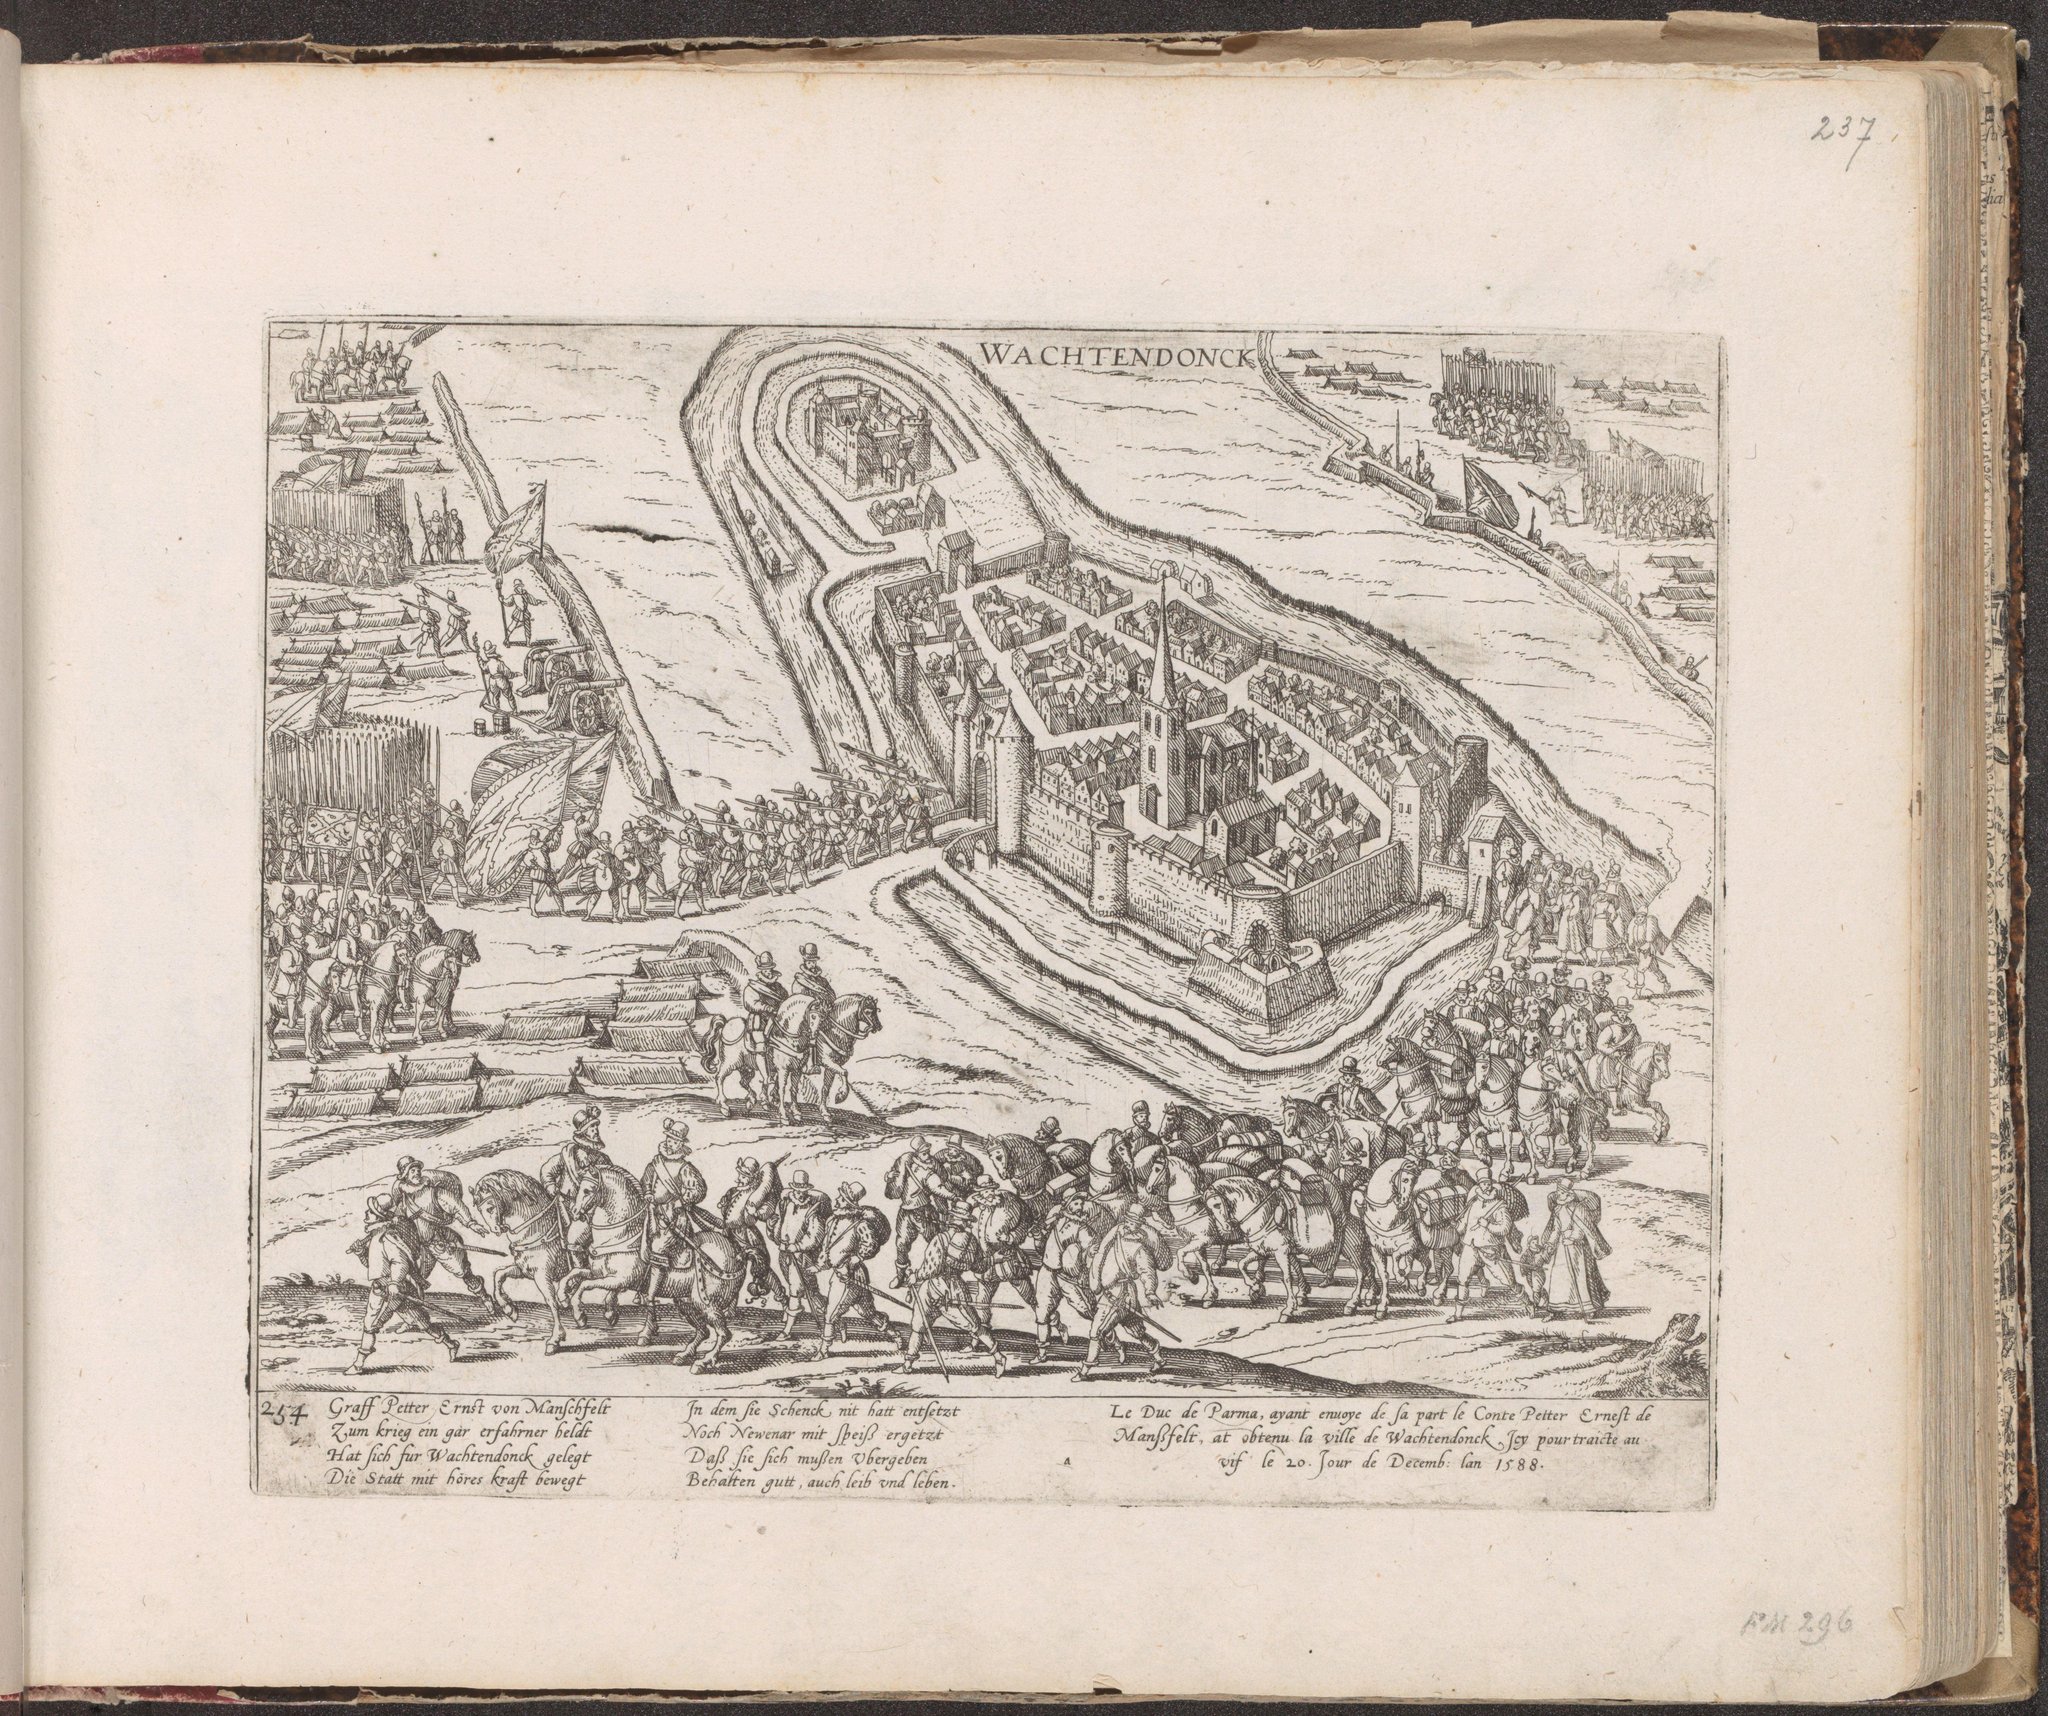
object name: album leaf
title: Overgave van Wachtendonk aan Mansfelt, 1588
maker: frans hogenberg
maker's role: print maker, publisher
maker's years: 1538-1590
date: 1588-1591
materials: paper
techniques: etching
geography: cologne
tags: capture of city (after the siege)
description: Overgave van Wachtendonk aan Mansfelt, 20 december 1588. Episode uit de Keulse Oorlog. Met onderschrift van 8 regels in het Duits en 3 regels in het Frans. Linksonder genummerd: 254. De prent maakt deel uit van een album.